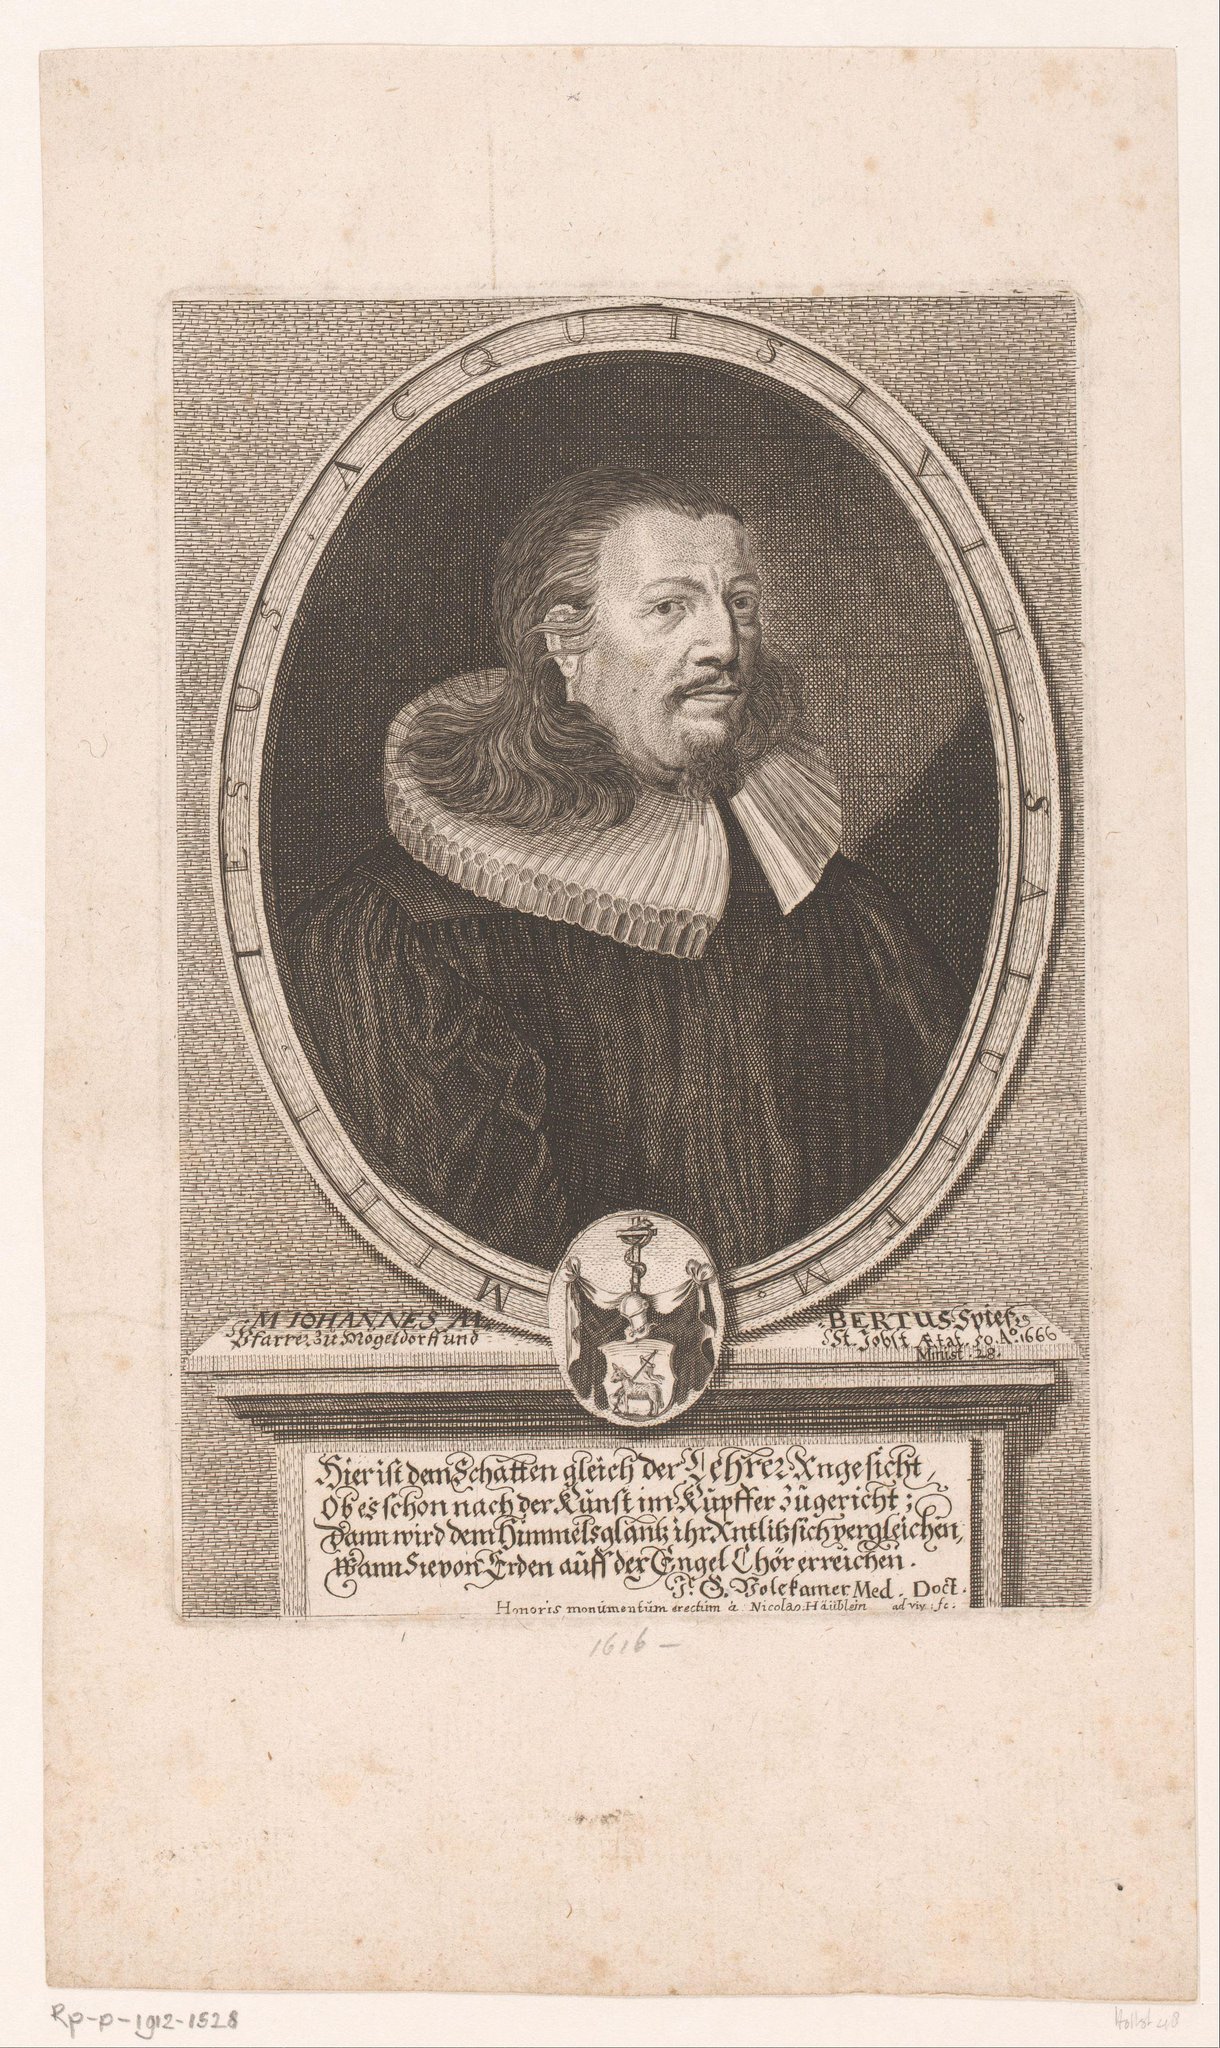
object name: print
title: Portret van Johann Albrecht Spiess op 50-jarige leeftijd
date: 1666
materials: paper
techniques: engraving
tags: historical persons, armorial bearing, heraldry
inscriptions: collector's mark: Lugt 2228